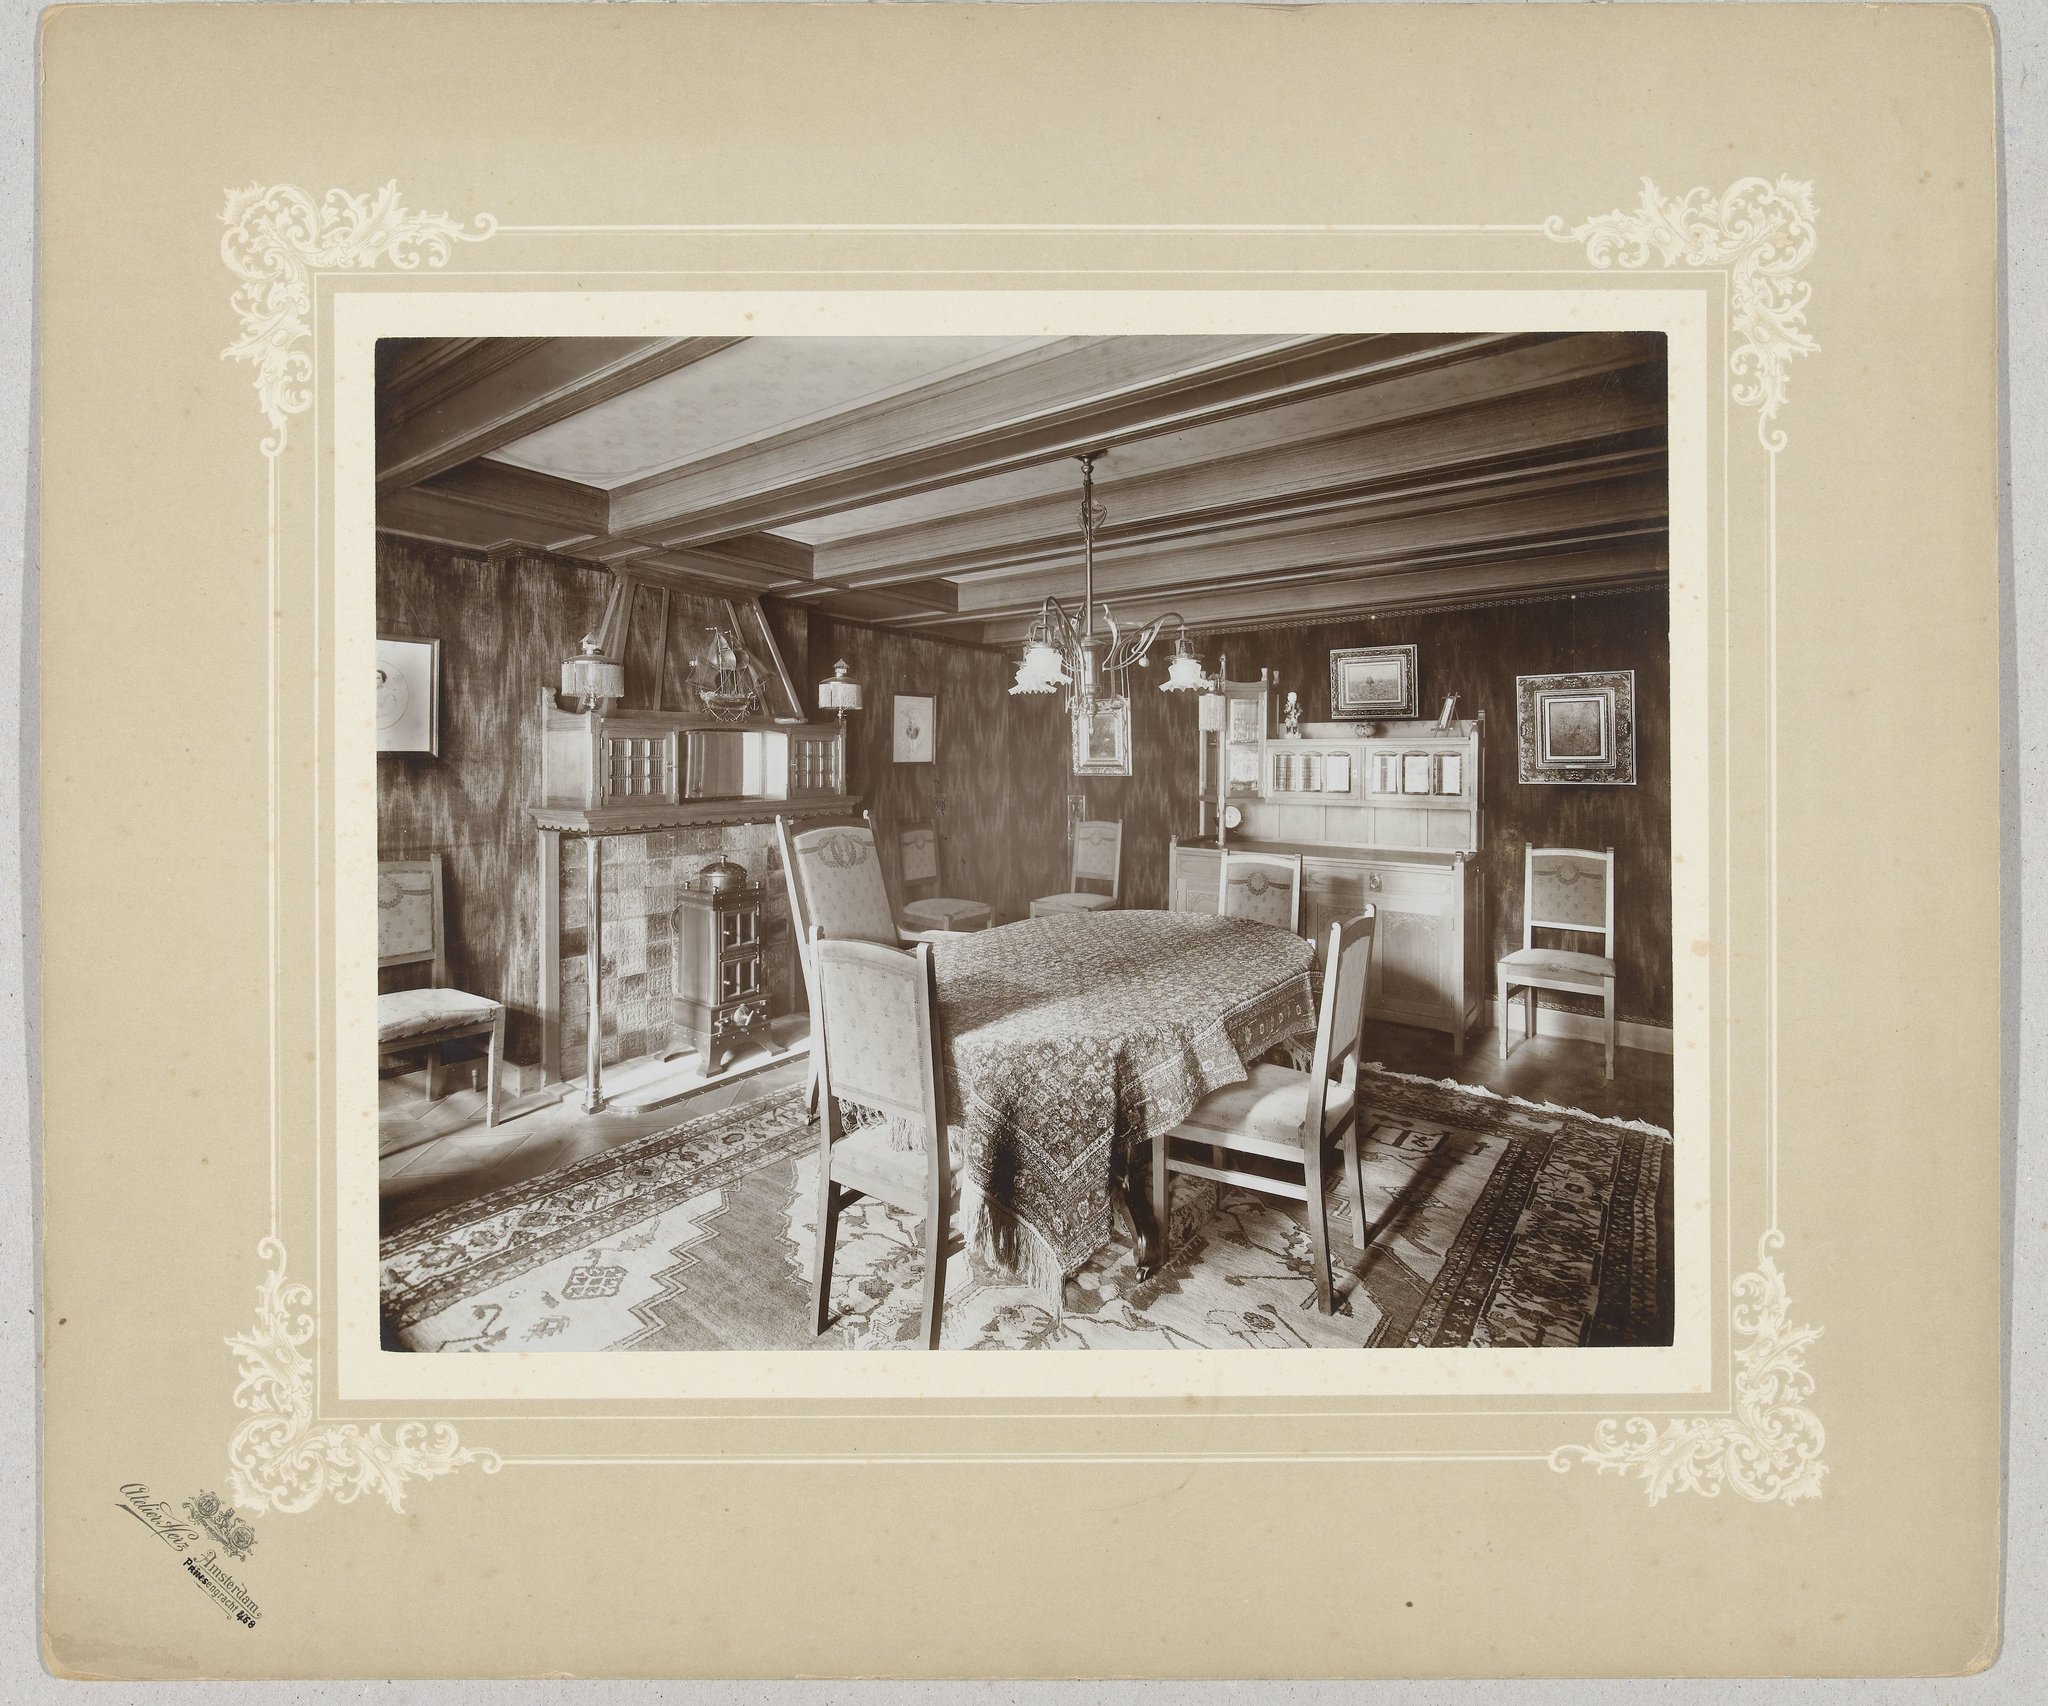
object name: photograph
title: Interieur tuinkamer, Keizersgracht 58, Amsterdam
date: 1905-1908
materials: cardboard, paper, photographic support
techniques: collodion silver print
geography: amsterdam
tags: interior ~ representation of a building, heating stove, dining-room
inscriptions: inscription: ‘Tuinkamer, Keizersgracht, 58. / Augustus 1905.’, inscription: ‘Atelier Herz / Amsterdam / Prinsengracht 458’